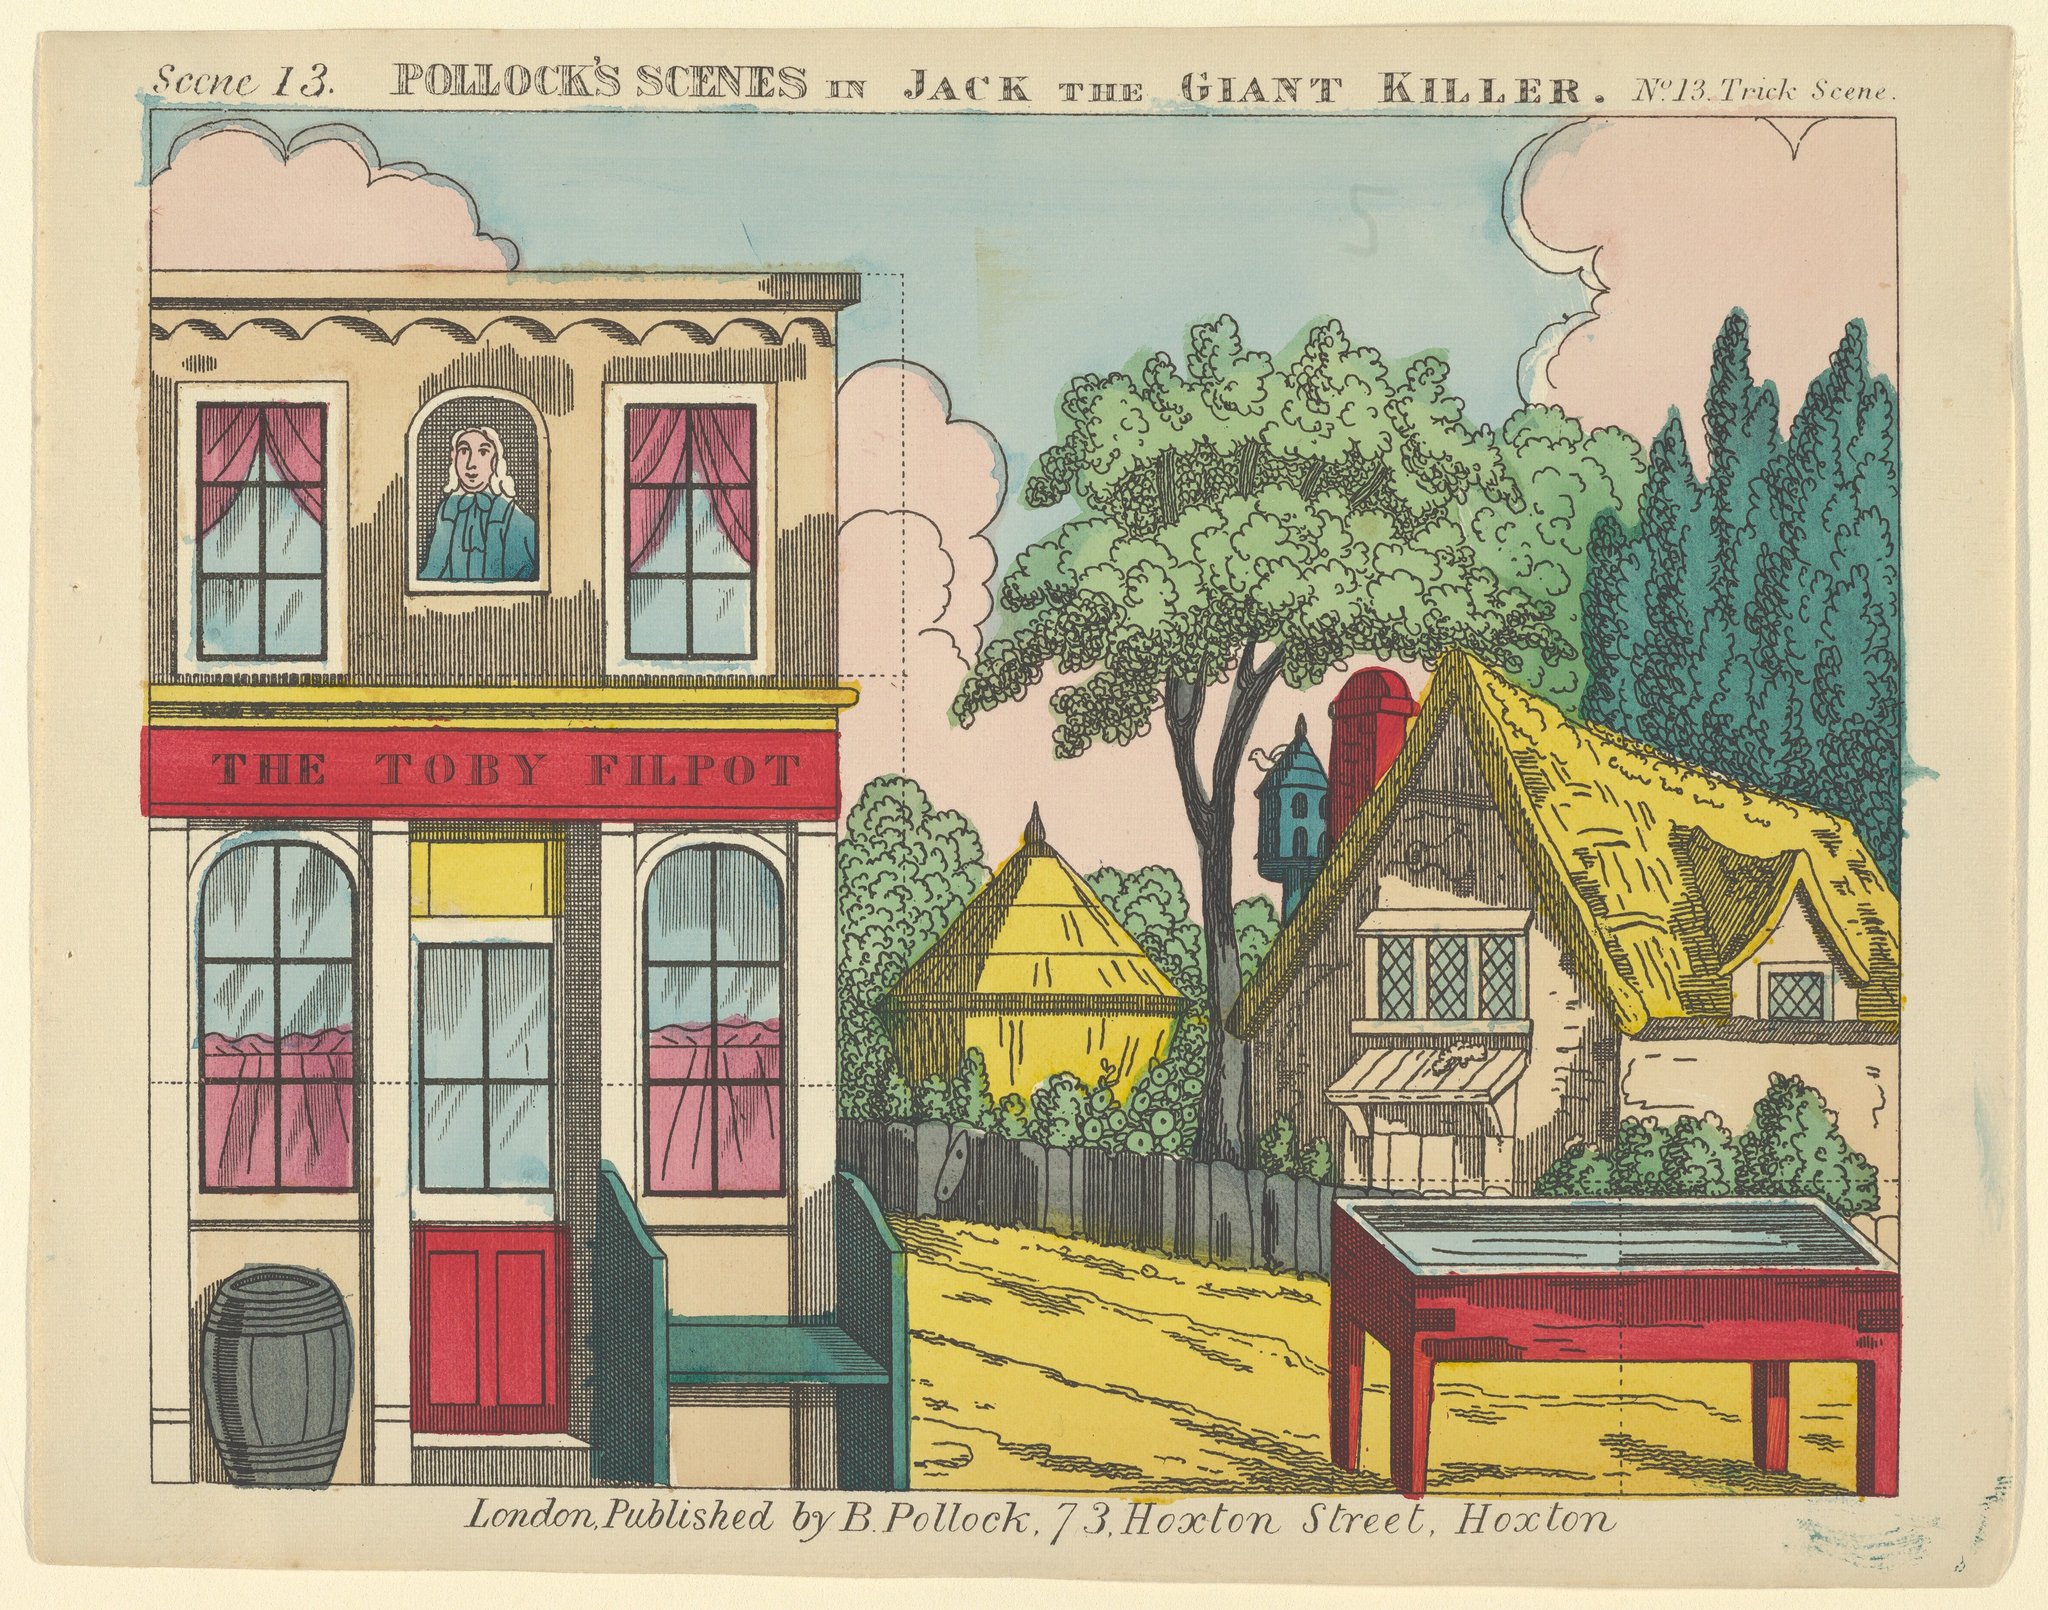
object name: print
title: Scene 13, from Jack and the Giant Killer, Trick Scene for a Toy Theater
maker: benjamin pollock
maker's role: publisher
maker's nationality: british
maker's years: 1857-1937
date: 1870-1890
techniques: lithograph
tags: buildings